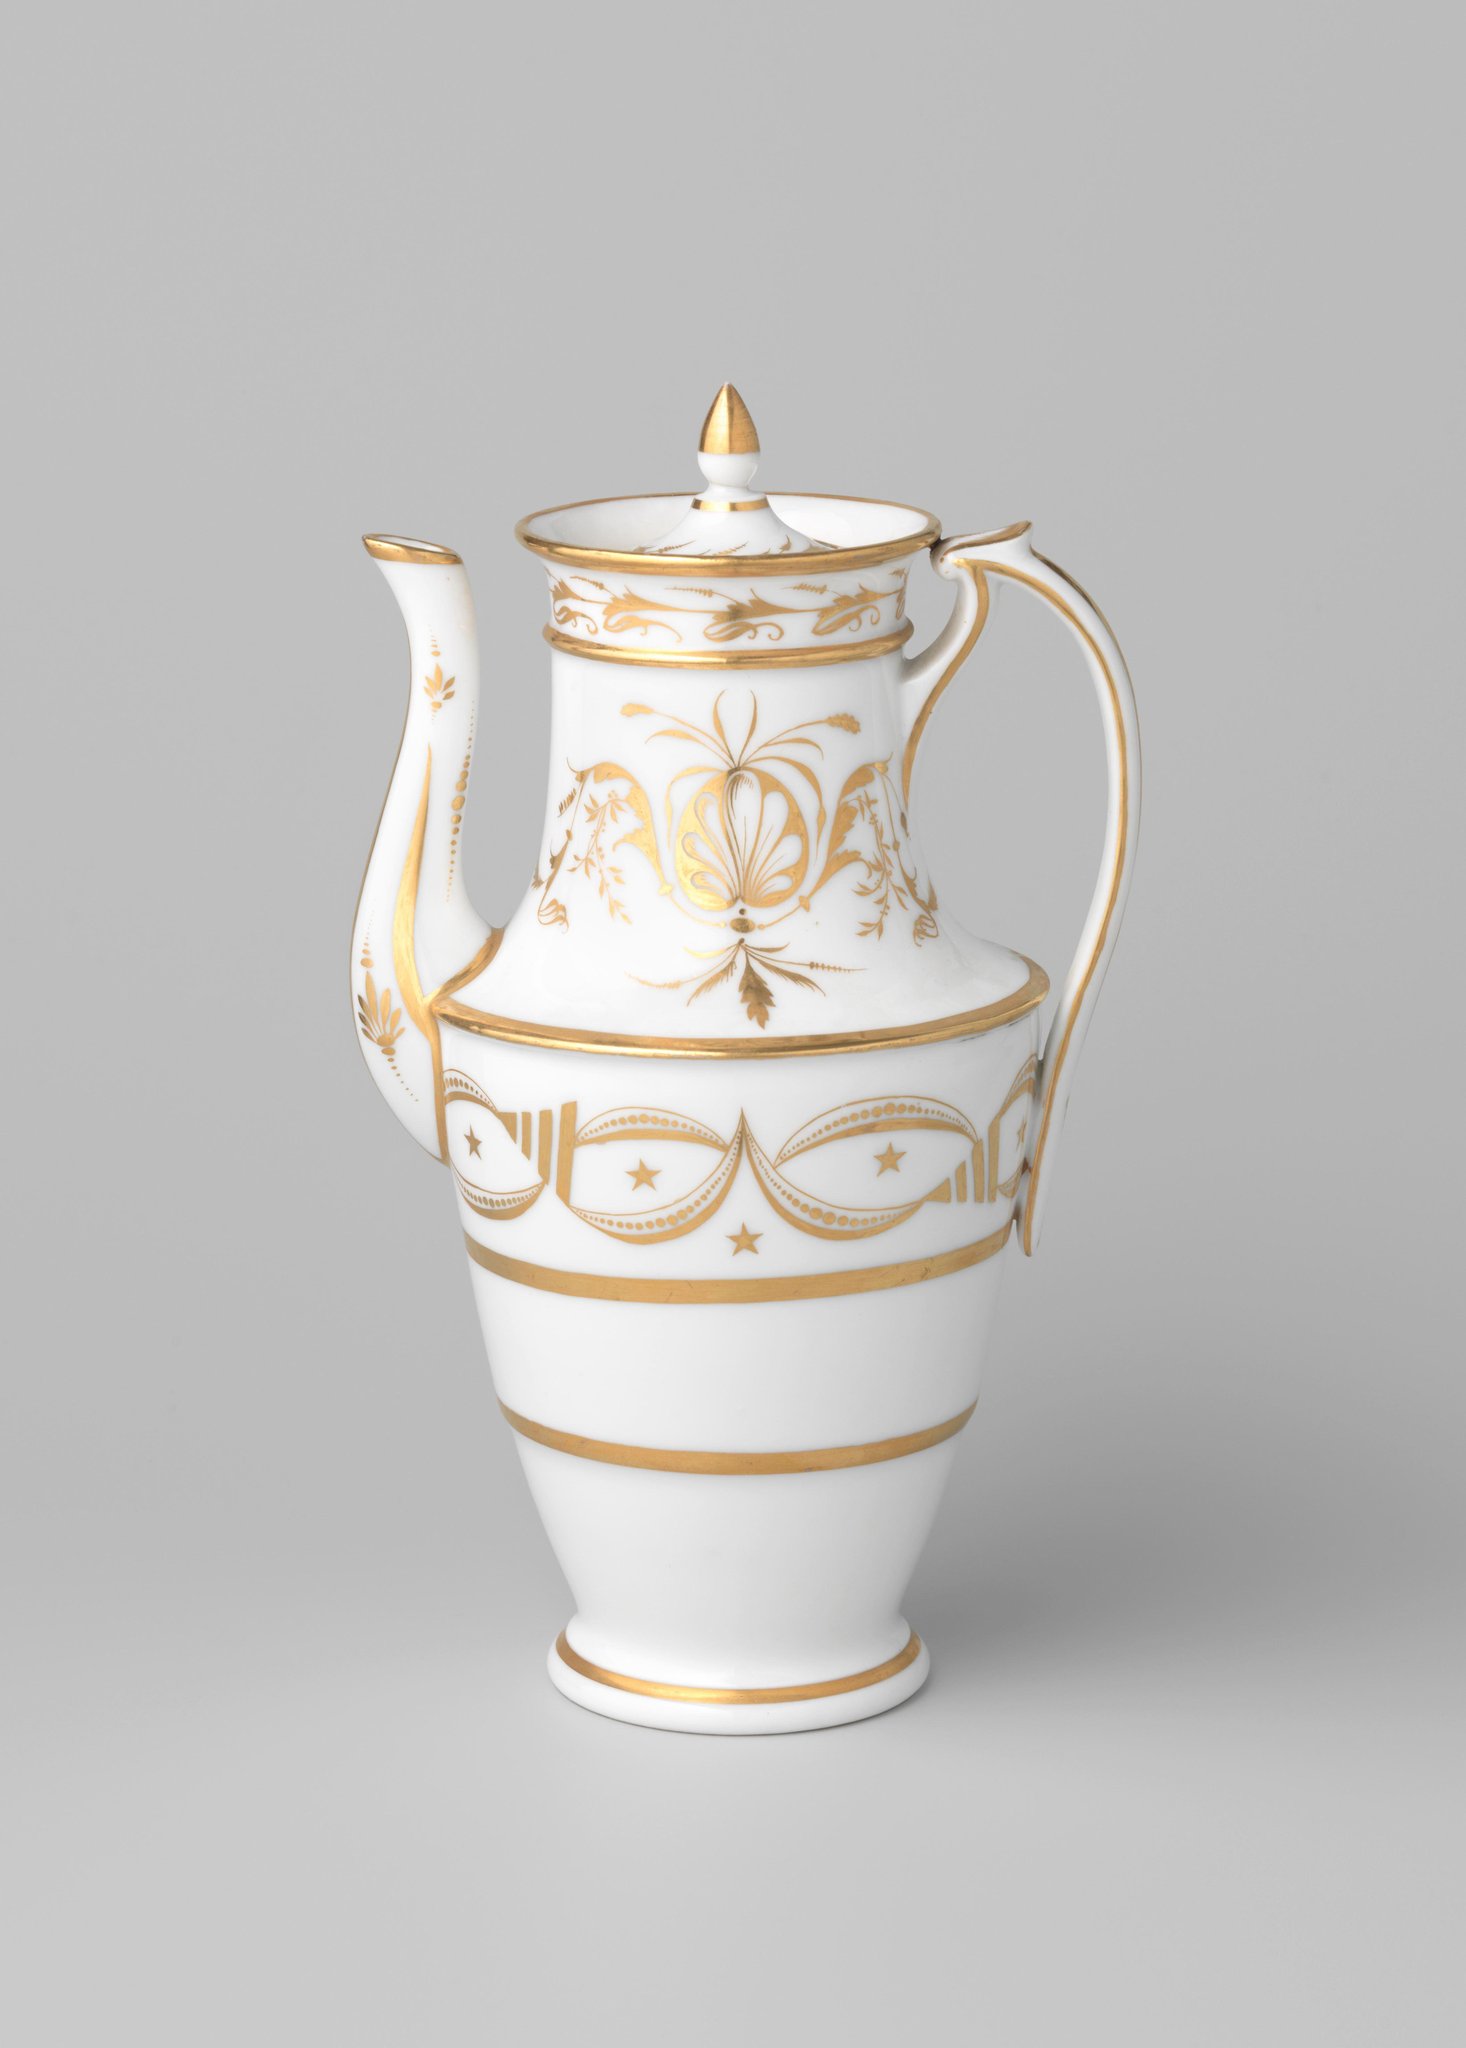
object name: coffee pot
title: Coffeepot with stylized flower sprays and ornamental borders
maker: Anonymous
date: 1800-1824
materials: glaze, gold, paint, porcelain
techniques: firing, forming, gilding, turning, vitrification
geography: france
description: Koffiekan van porselein, beschilderd op het glazuur in goud. De kan heeft een vaasvormig lichaam, S-vormige tuit en een hoog oor, waarvan de bovenzijde is verbonden met de rand. De buik is met gouden lijnen verdeeld in drie brede banden met in de bovenste een slinger van sterren, halve maanvormen met stippen en driehoeken. Op de nek tweemaal een gestileerde bloemtak en op de rand bloemranken. De tuit met gouden lijnen en gestileerde bloemen. De deksel met een band bloemranken. Empire.